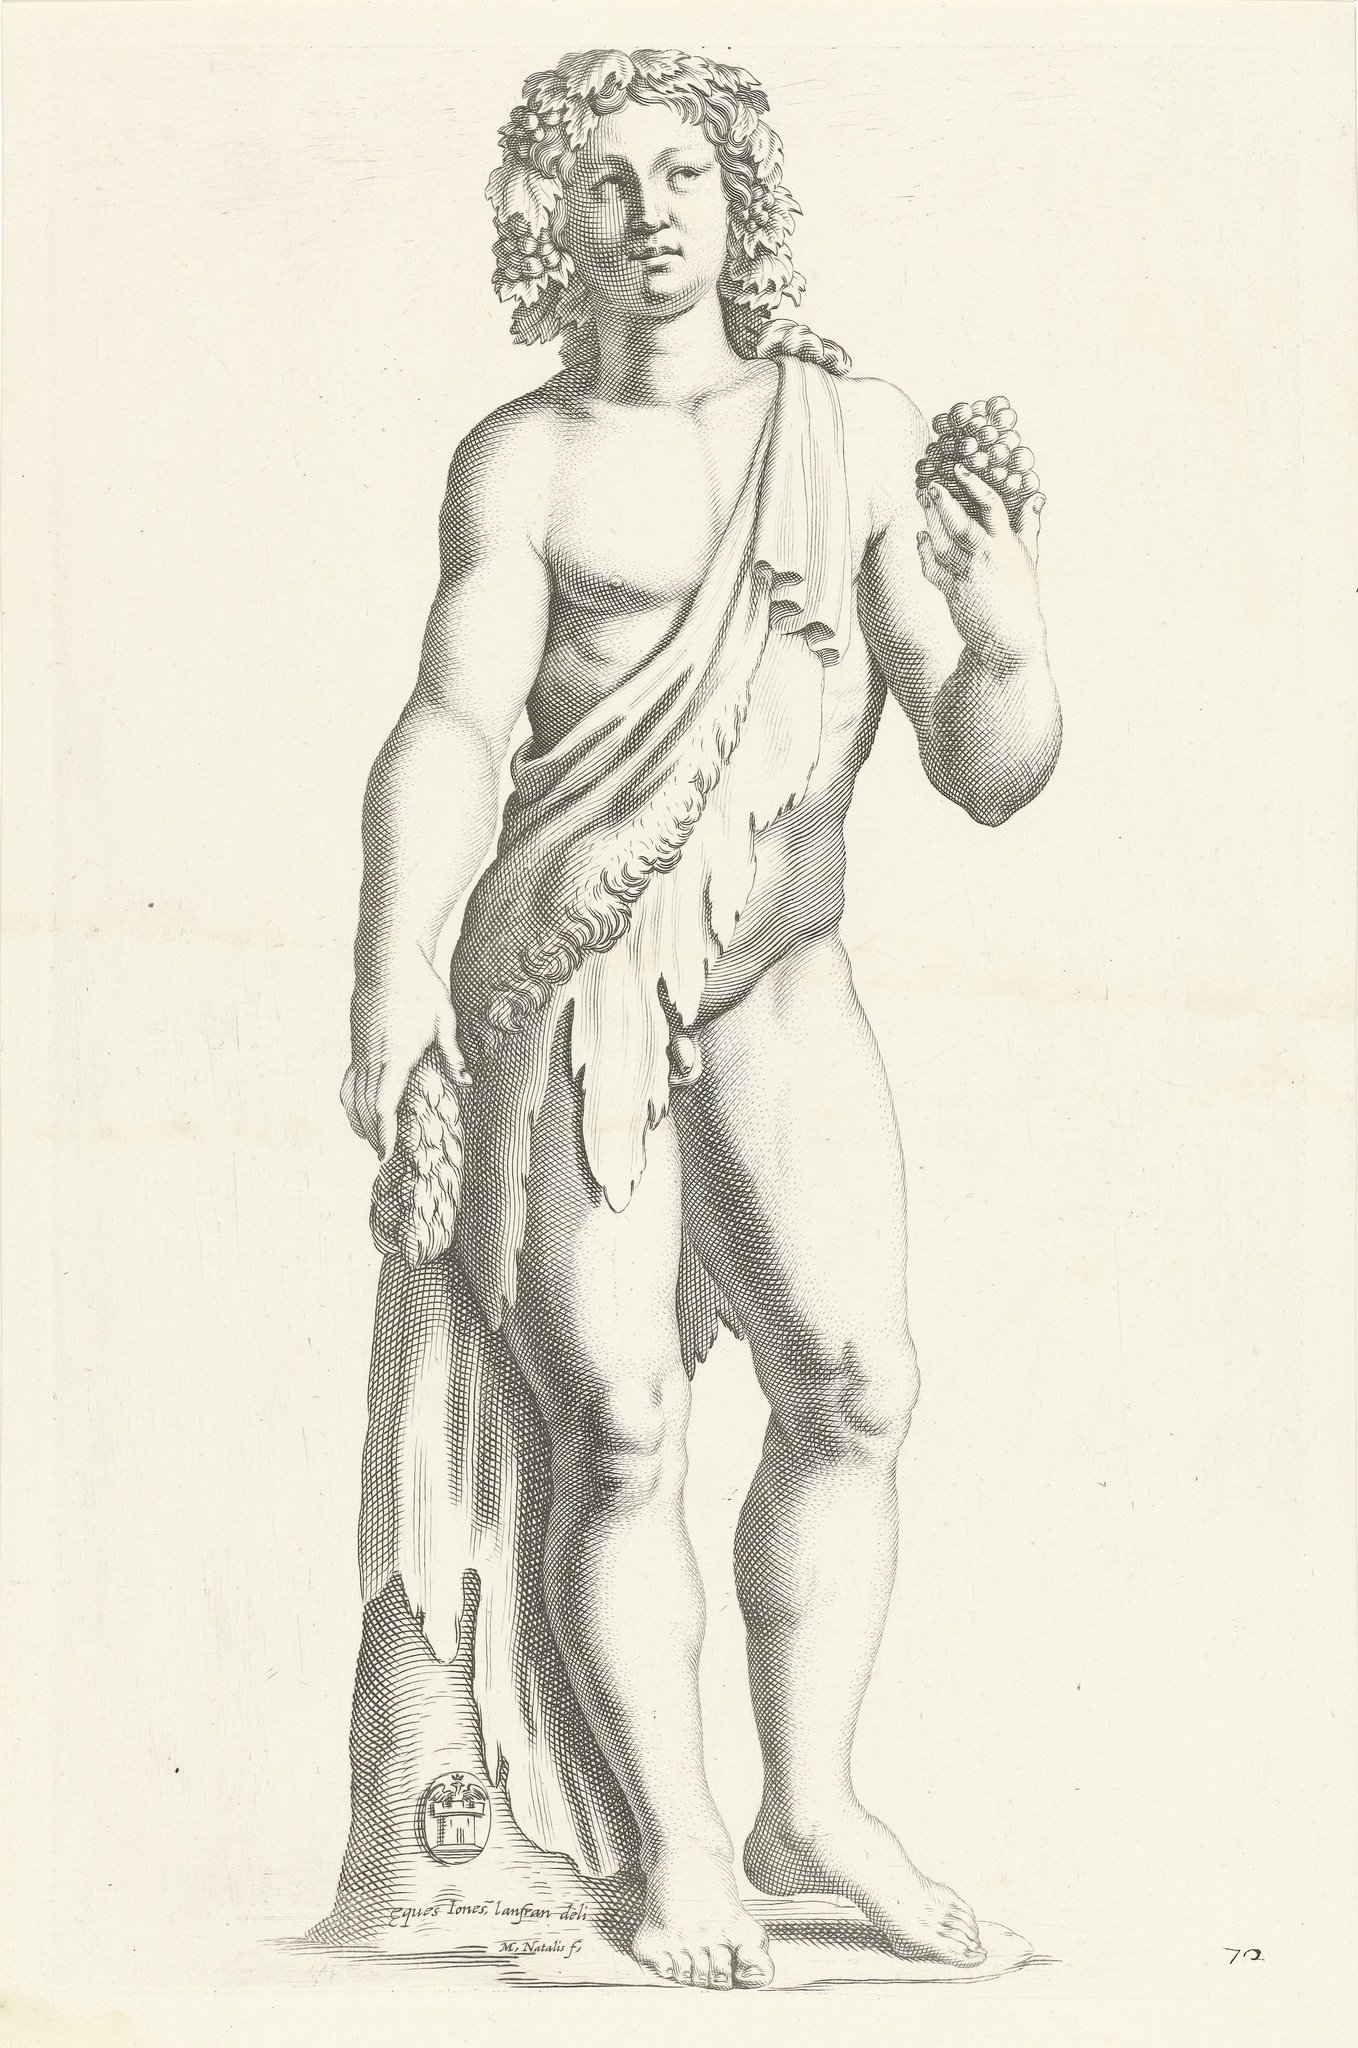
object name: print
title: Galleria Giustiniana del Marchese Vincenzo Giustiniani I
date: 1640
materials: paper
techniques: engraving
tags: vincenzo giustiniani (1564-1637), (story of) bacchus (dionysus), liber, piece of sculpture, reproduction of a piece of sculpture, monument, statue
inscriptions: collector's mark: Lugt 2228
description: Standbeeld van Bacchus, een dierenvel schuin over de schouder, met in zijn linkerhand een druiventros. In zijn haren draagt hij wingerdbladeren en druiventrossen. Midden onder op de boomstam het wapenschild van Vincenzo Giustiniani. Prent uit een serie naar de sculpturen in de verzameling in de Galleria Giustiniani te Rome.